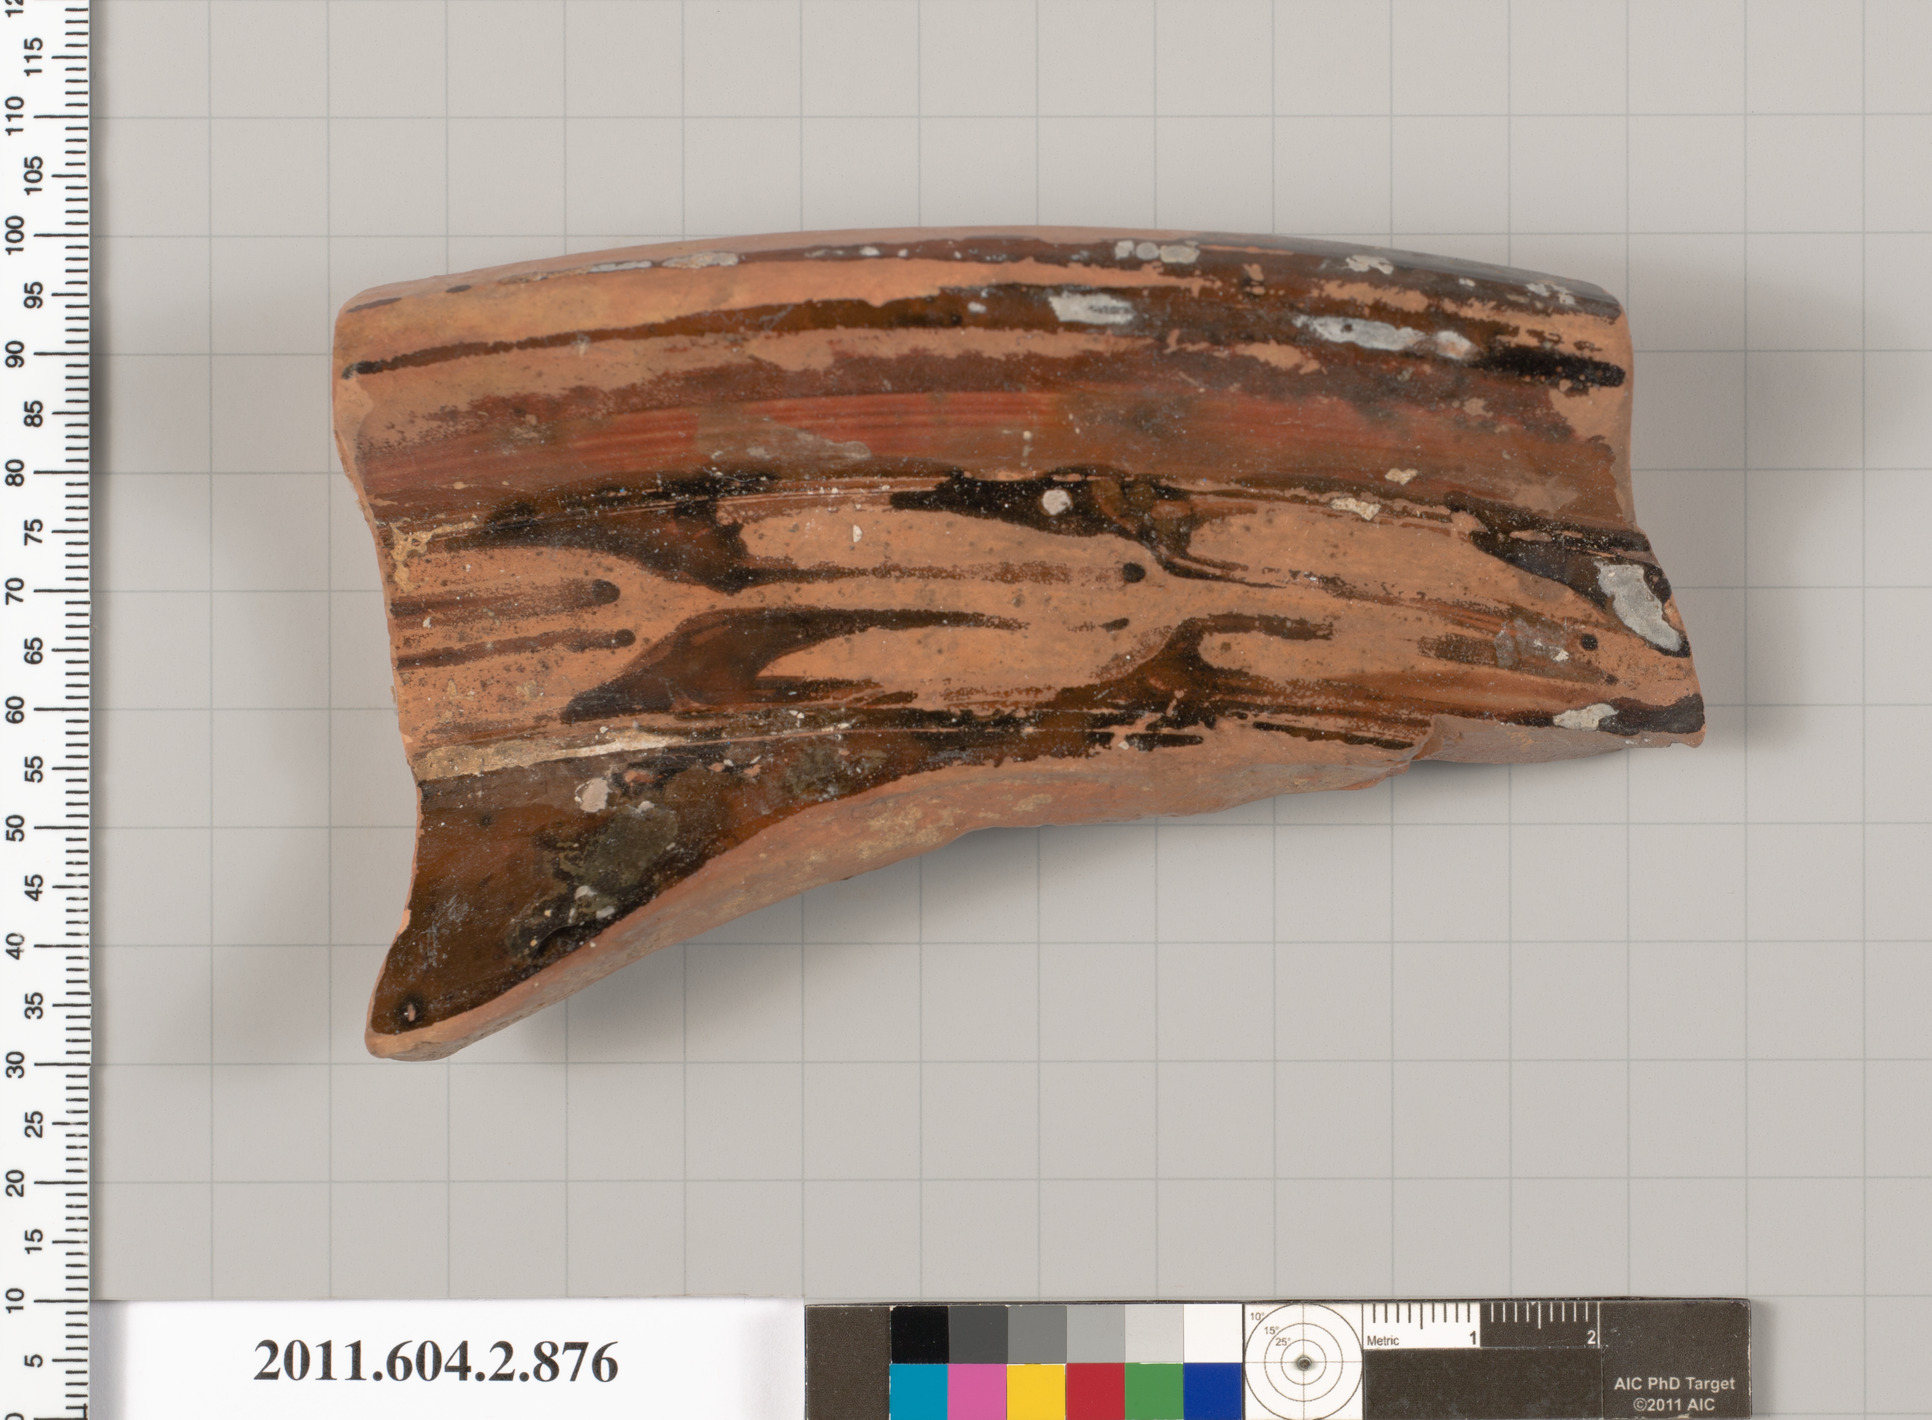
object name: bell krater fragment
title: Terracotta fragment of a bell-krater (bowl for mixing wine and water)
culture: greek, attic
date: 425-401 BCE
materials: terracotta